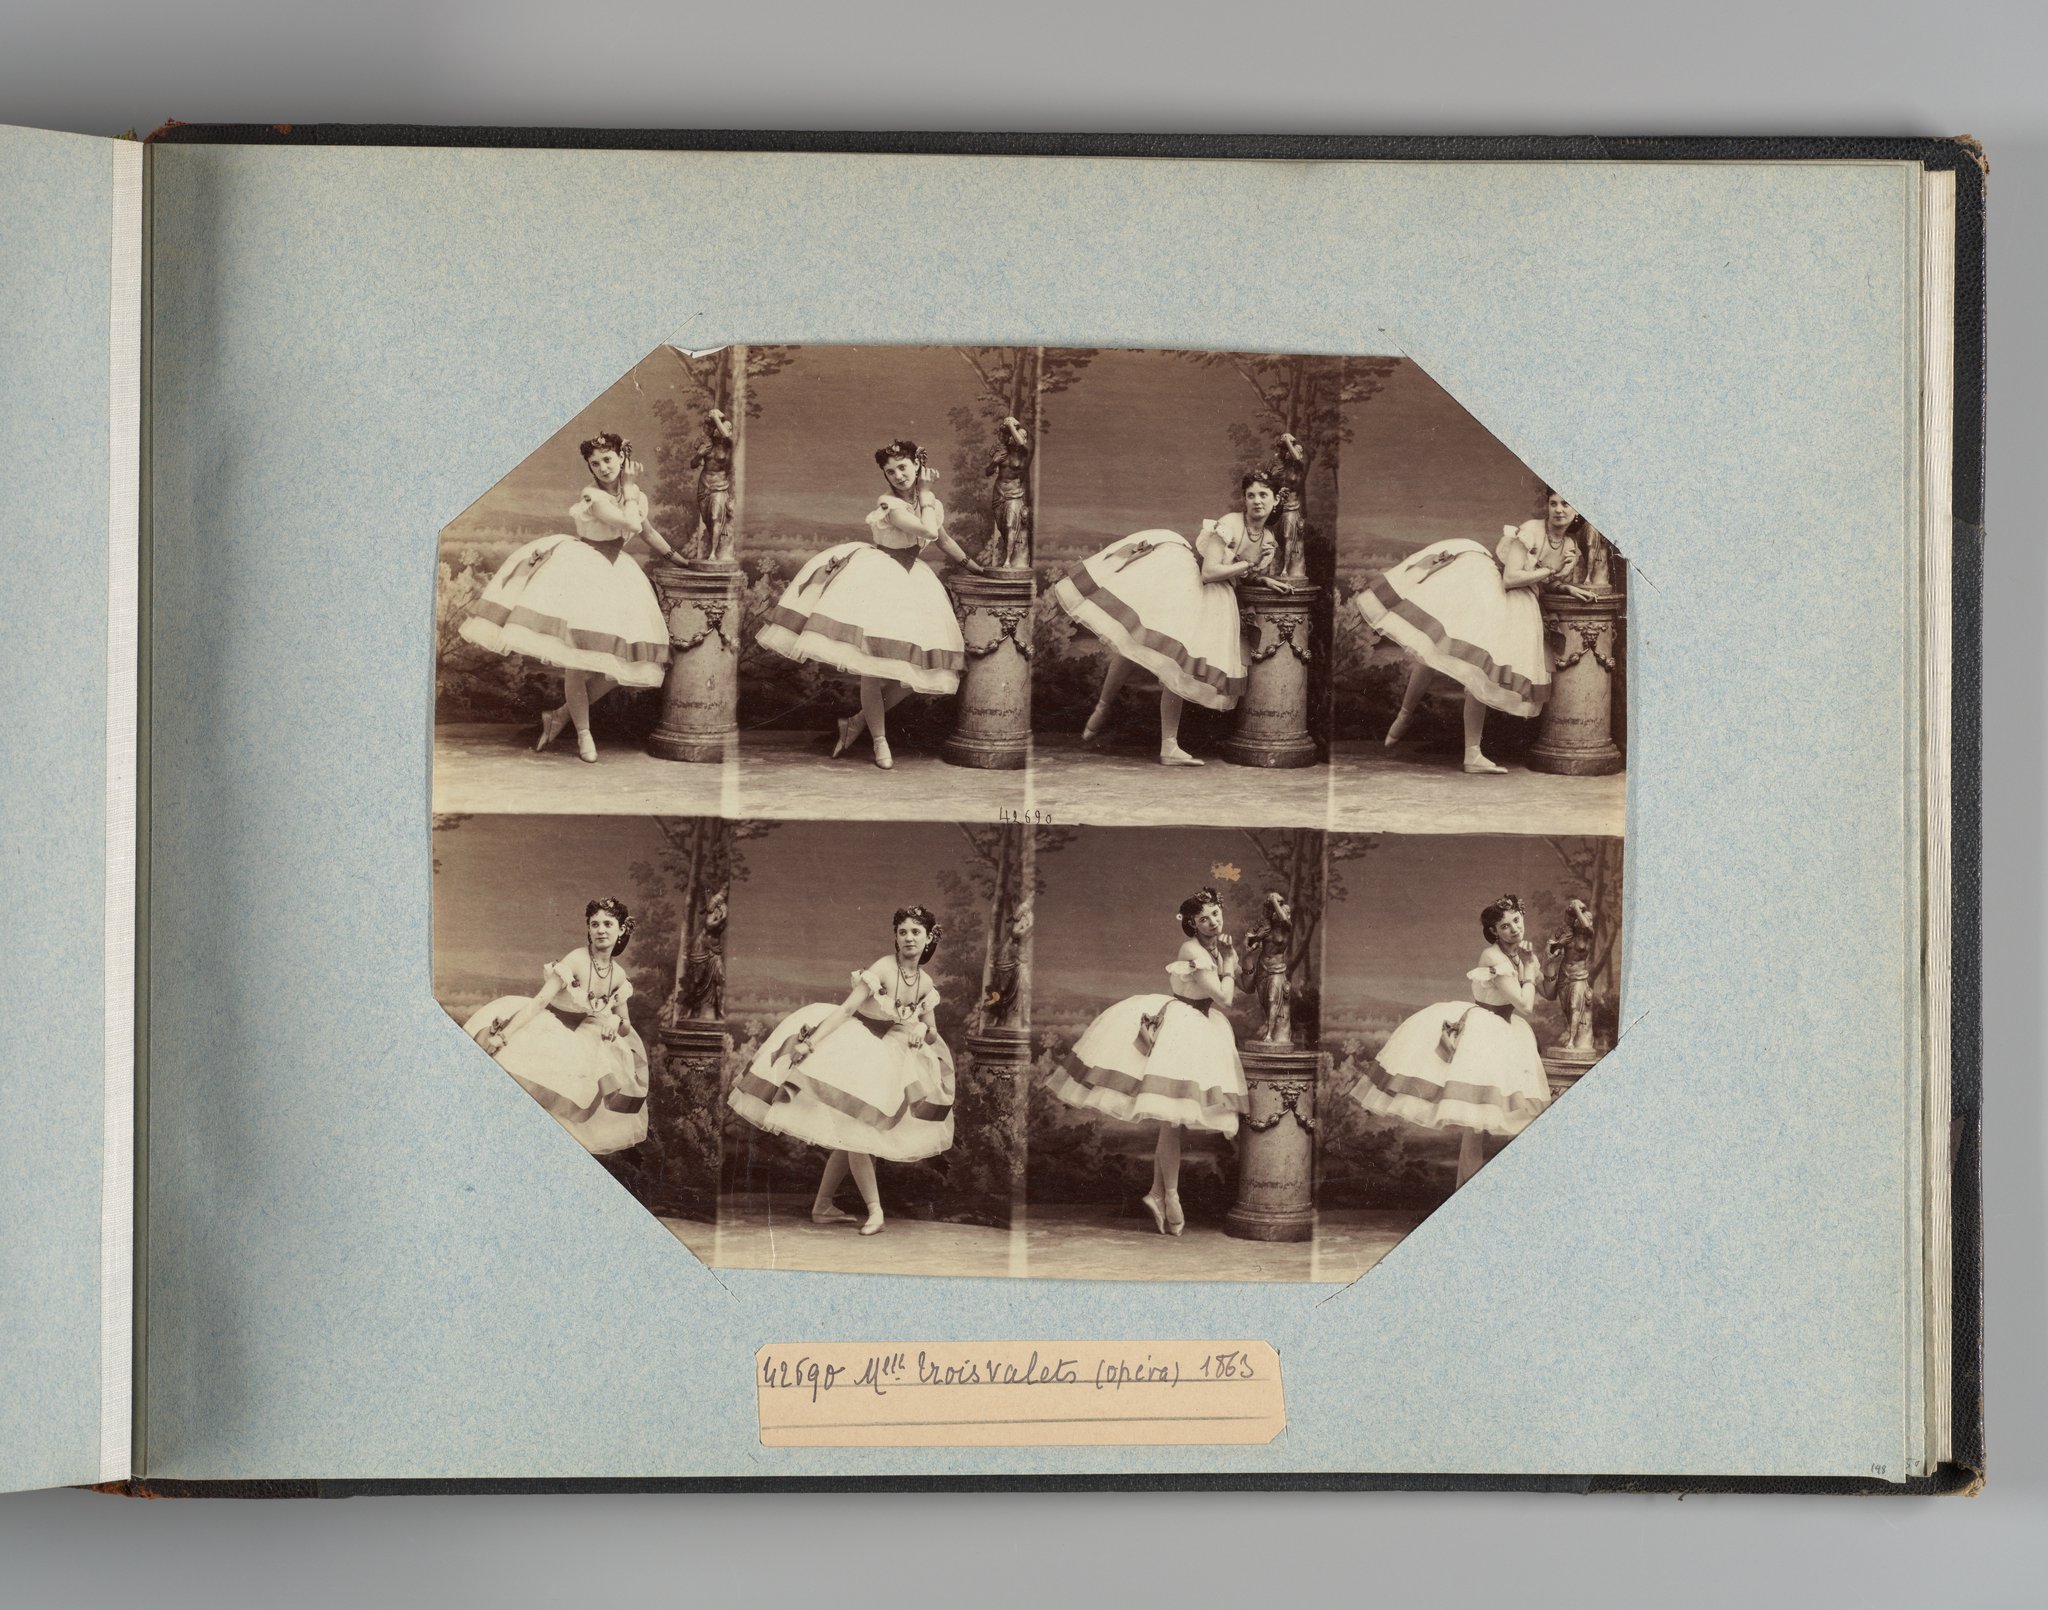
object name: photograph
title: Mlle Troisvalets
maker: andré-adolphe-eugène disdéri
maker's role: artist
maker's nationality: french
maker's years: 1819-1889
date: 1863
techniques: albumen silver print, glass negative